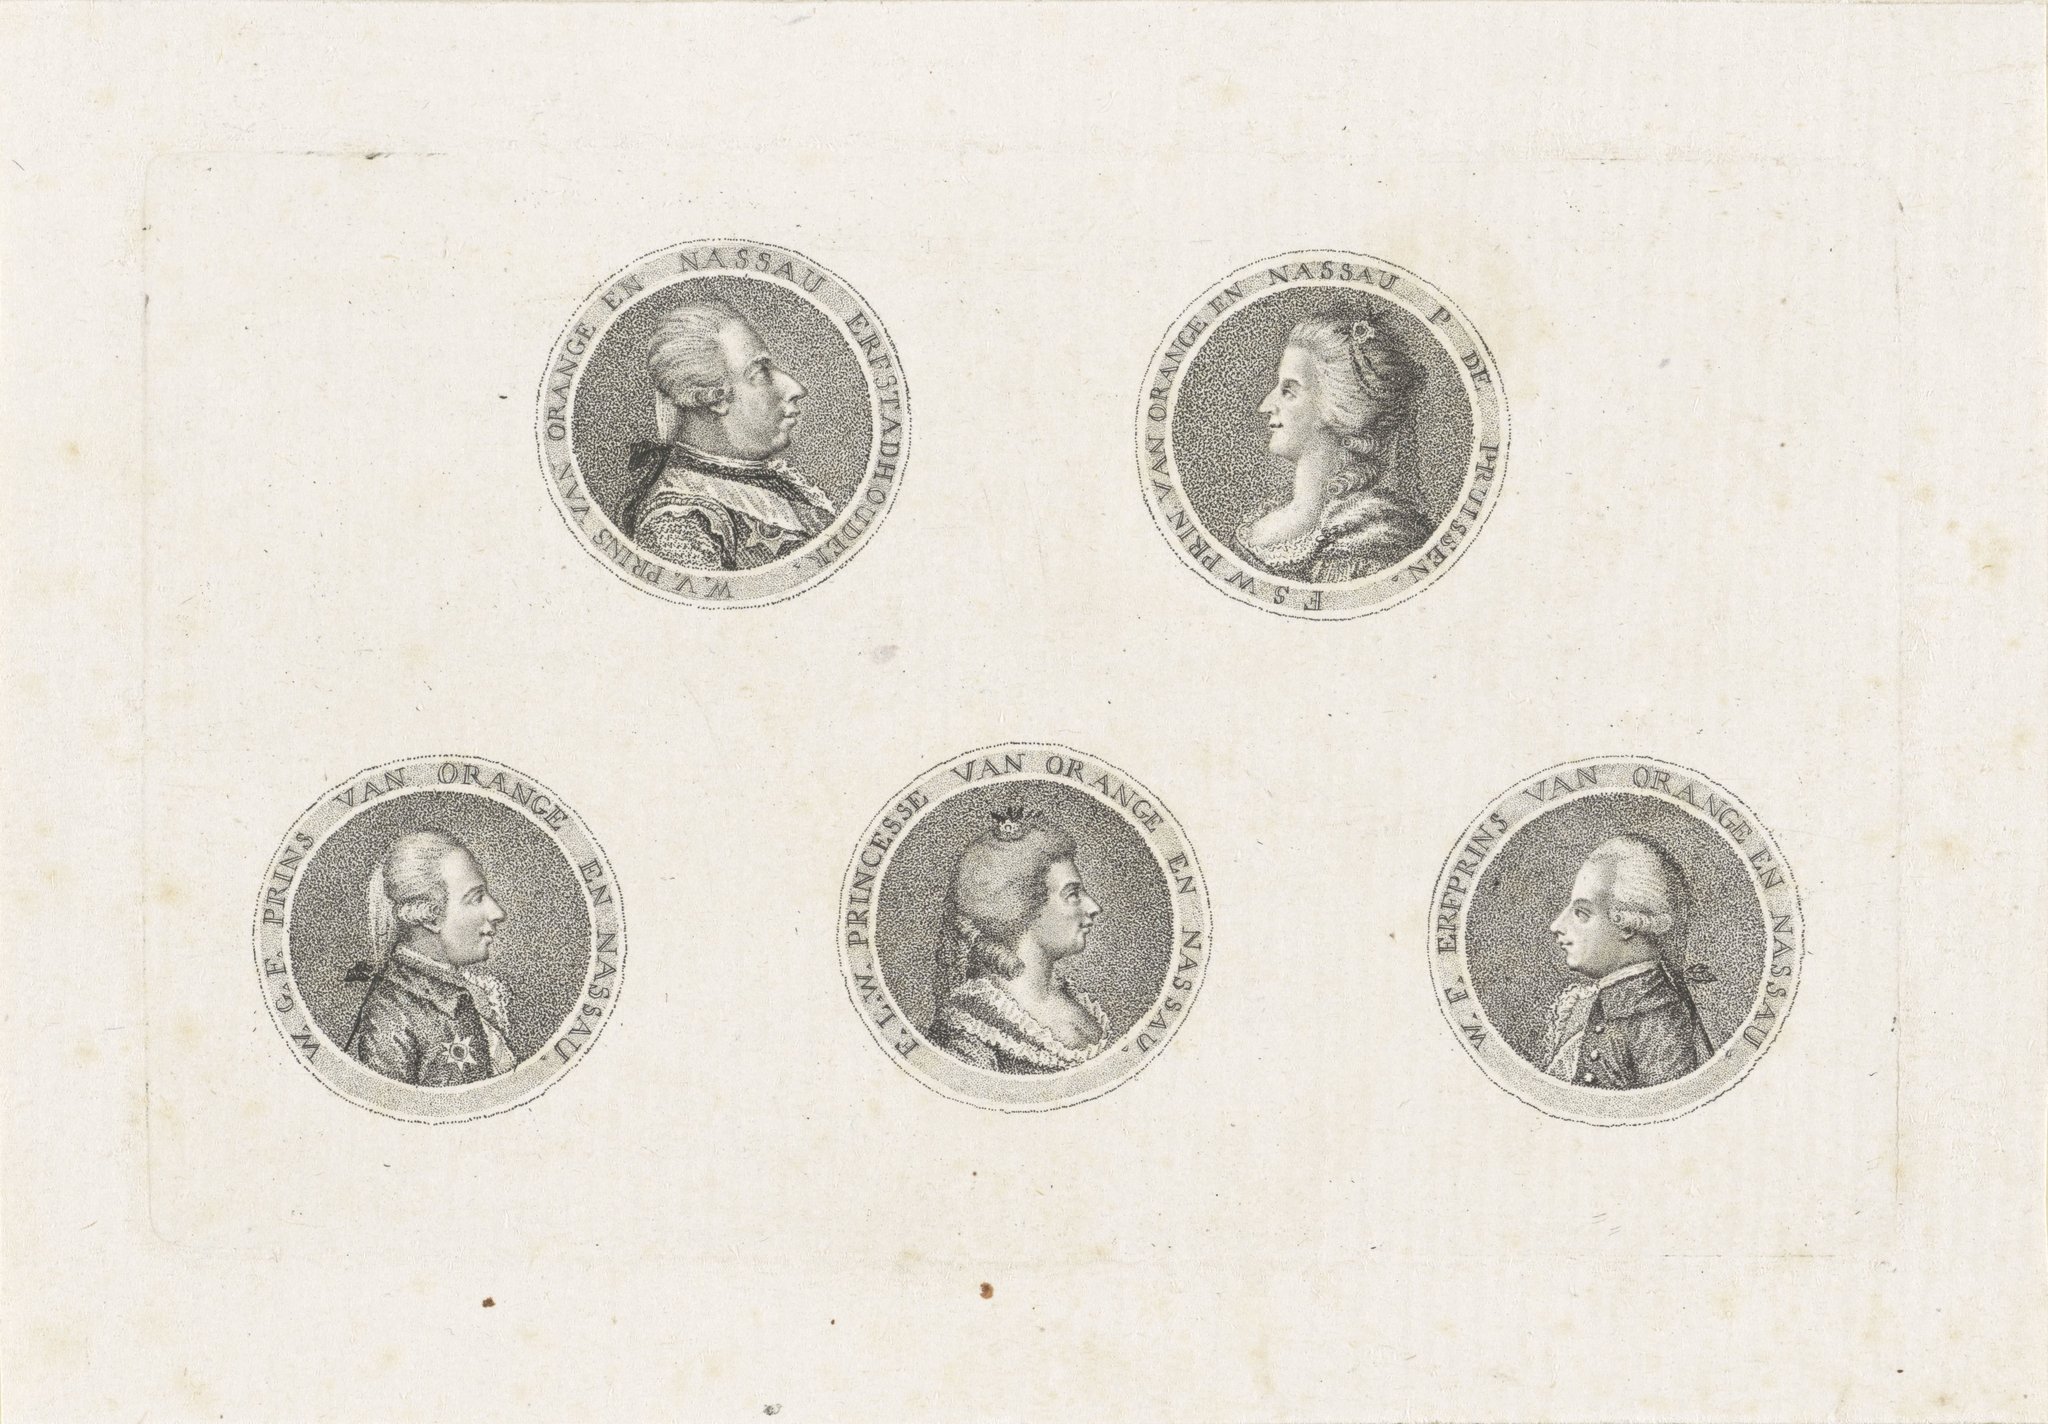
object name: print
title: Penningen met portretten van Willem V, prins van Oranje-Nassau, Wilhelmina van Pruisen, Frederik, prins van Oranje-Nassau, Louise, prinses van Oranje-Nassau, en Willem I Frederik, koning der Nederlanden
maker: Anonymous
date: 1785-1849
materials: paper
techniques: engraving, etching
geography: low countries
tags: the hague, william v (prince of orange), william i of the netherlands, berlin, painter, draughtsman, wilhelmina of prussia (princess of orange), louise (prinses van oranje-nassau), willem george frederik (prins van oranje-nassau)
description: Boven: Portret van Willem V in een cirkel met randschrift links en portret van Wilhelmina in een cirkel met randschrift rechts. Onder: Portret van Frederik in een cirkel met randschrift links, portret van Louise in een cirkel met randschrift in het midden en portret van Willem I Frederik in een cirkel met randschrift rechts.